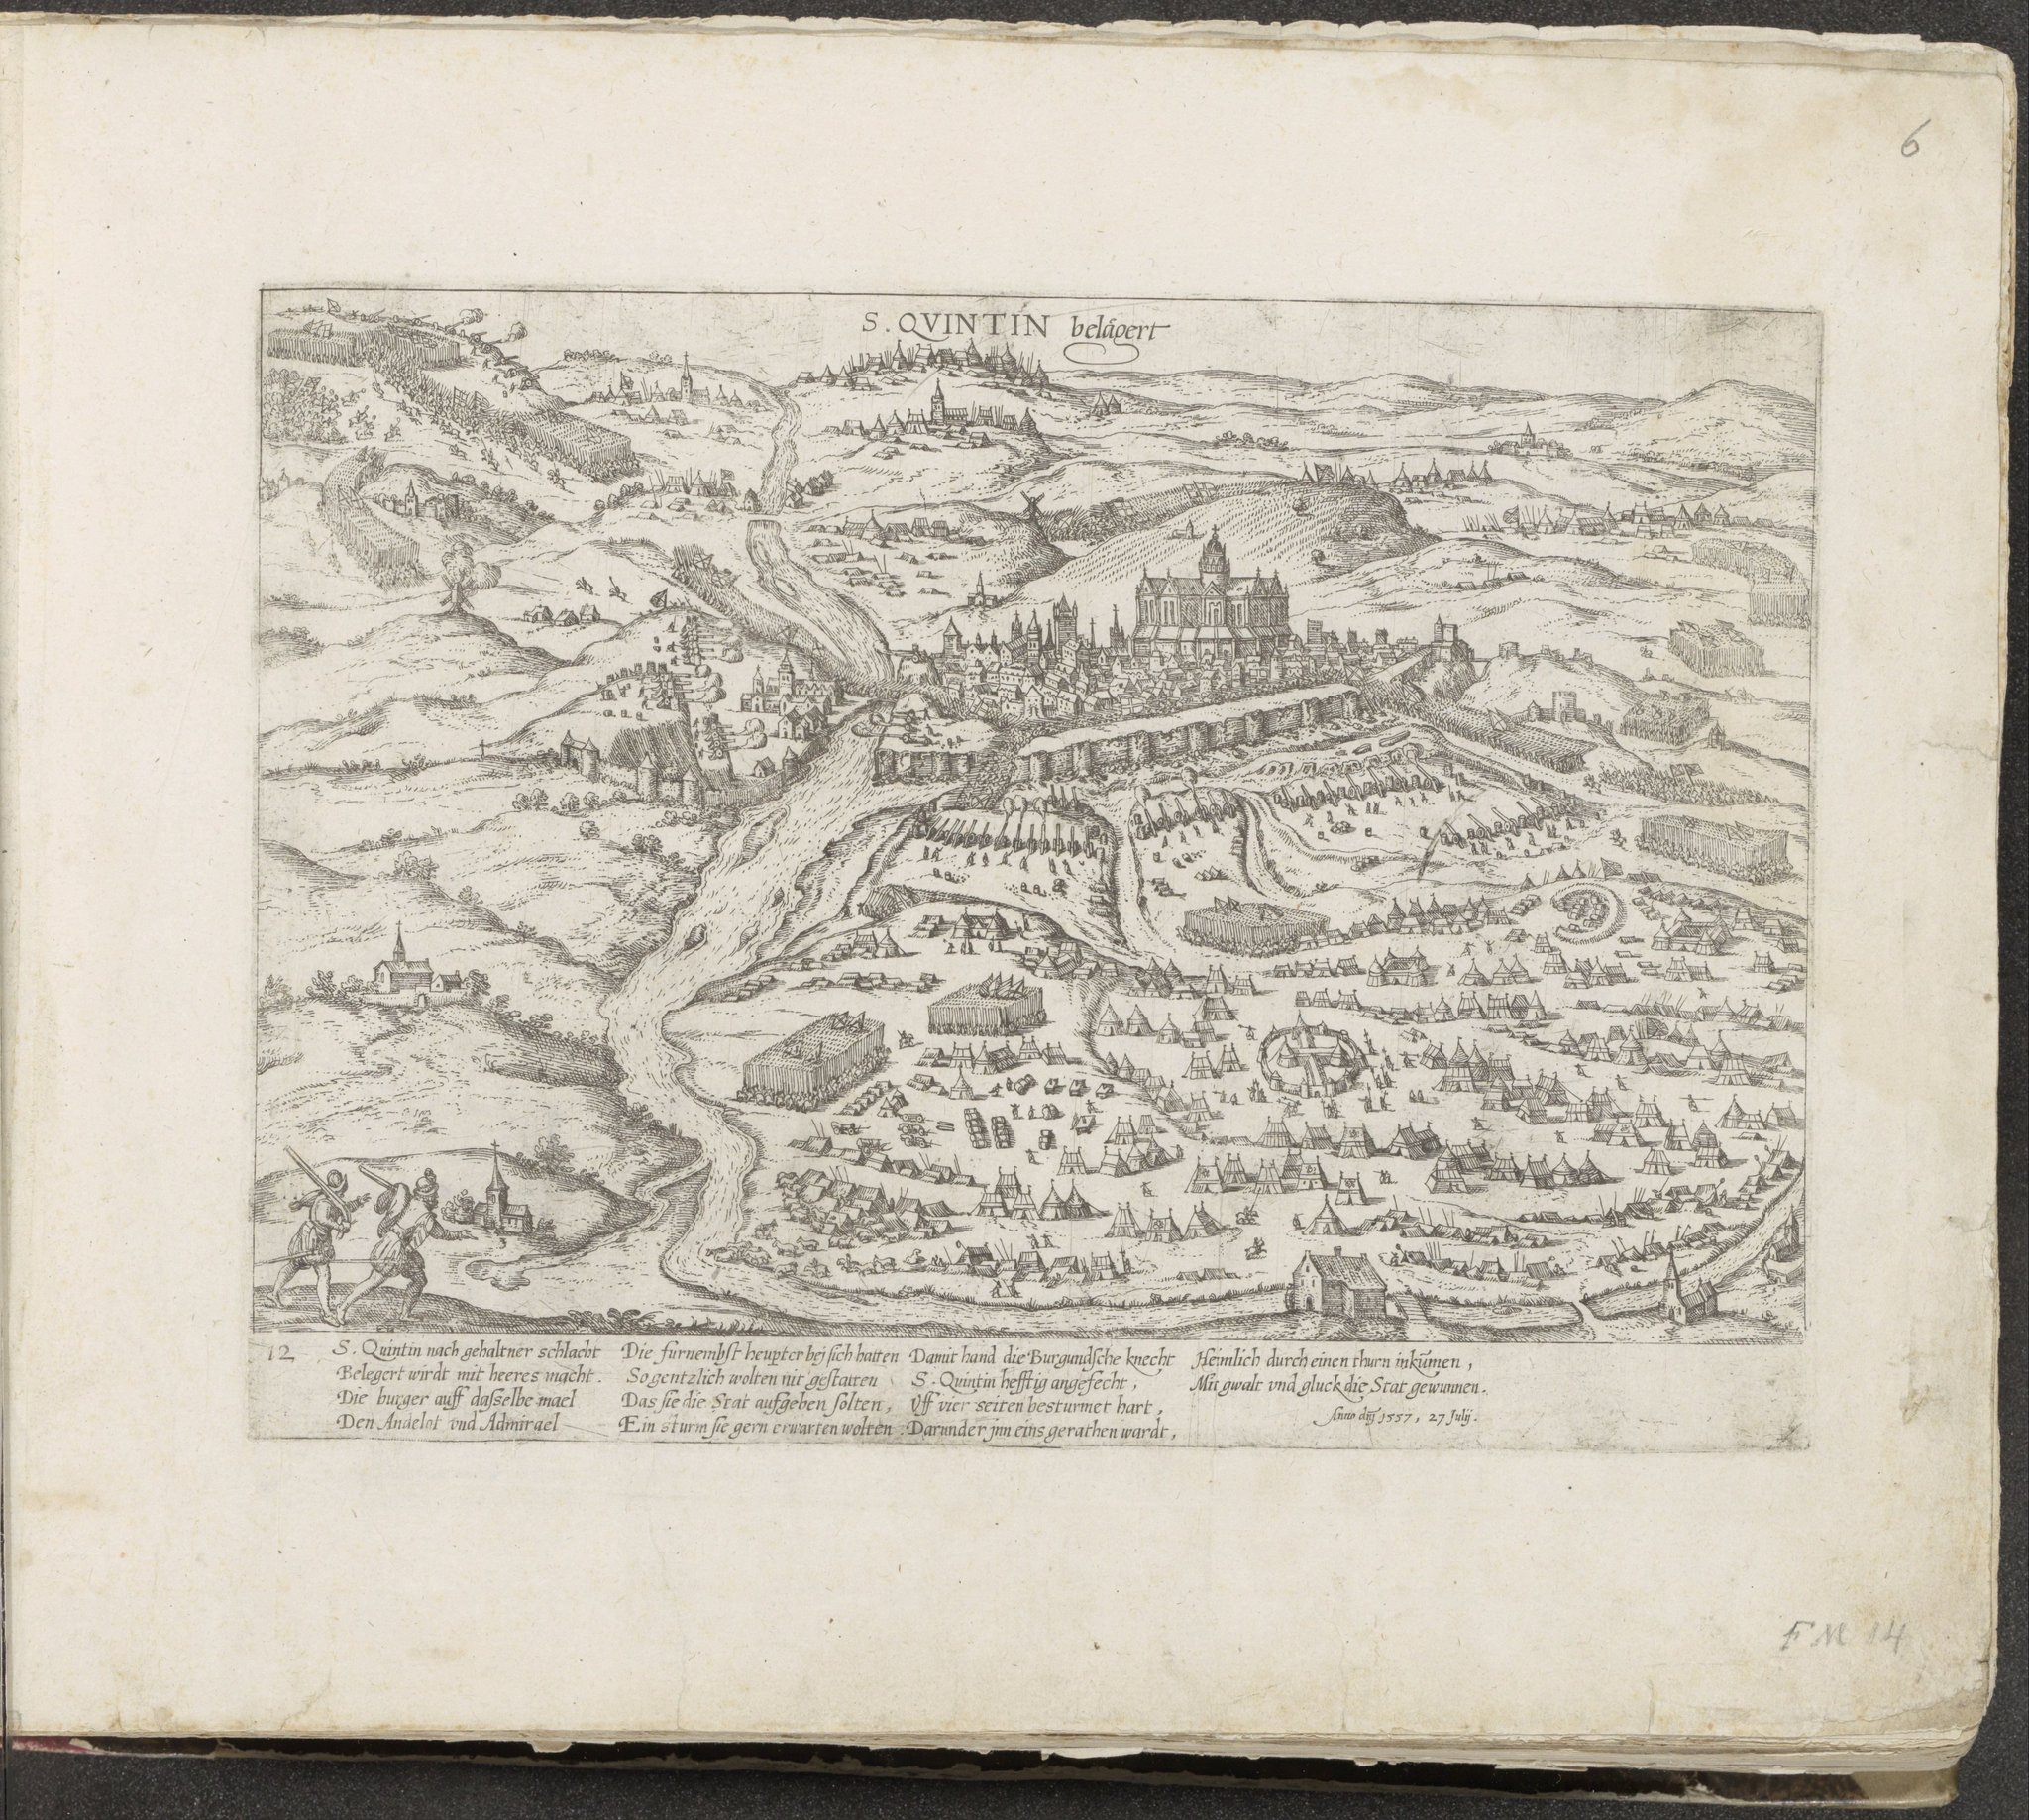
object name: print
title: S. Quintin belägert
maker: frans hogenberg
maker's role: print maker, publisher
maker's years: 1538-1590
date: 1568-1572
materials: paper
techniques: etching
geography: cologne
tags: philip ii of spain, emanuel filibert (hertog van savoye), siege, position war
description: Beleg van de Franse stad Saint-Quentin door de troepen van Filips II en Emanuel van Savoye, 27 juli 1557-10 augustus 1557. Gezicht op de stad en de posities van de belegeraars in vogelvluchtperspectief. Met onderschrift van 14 regels in het Duits. Linksonder genummerd: 12. De prent maakt deel uit van een album.